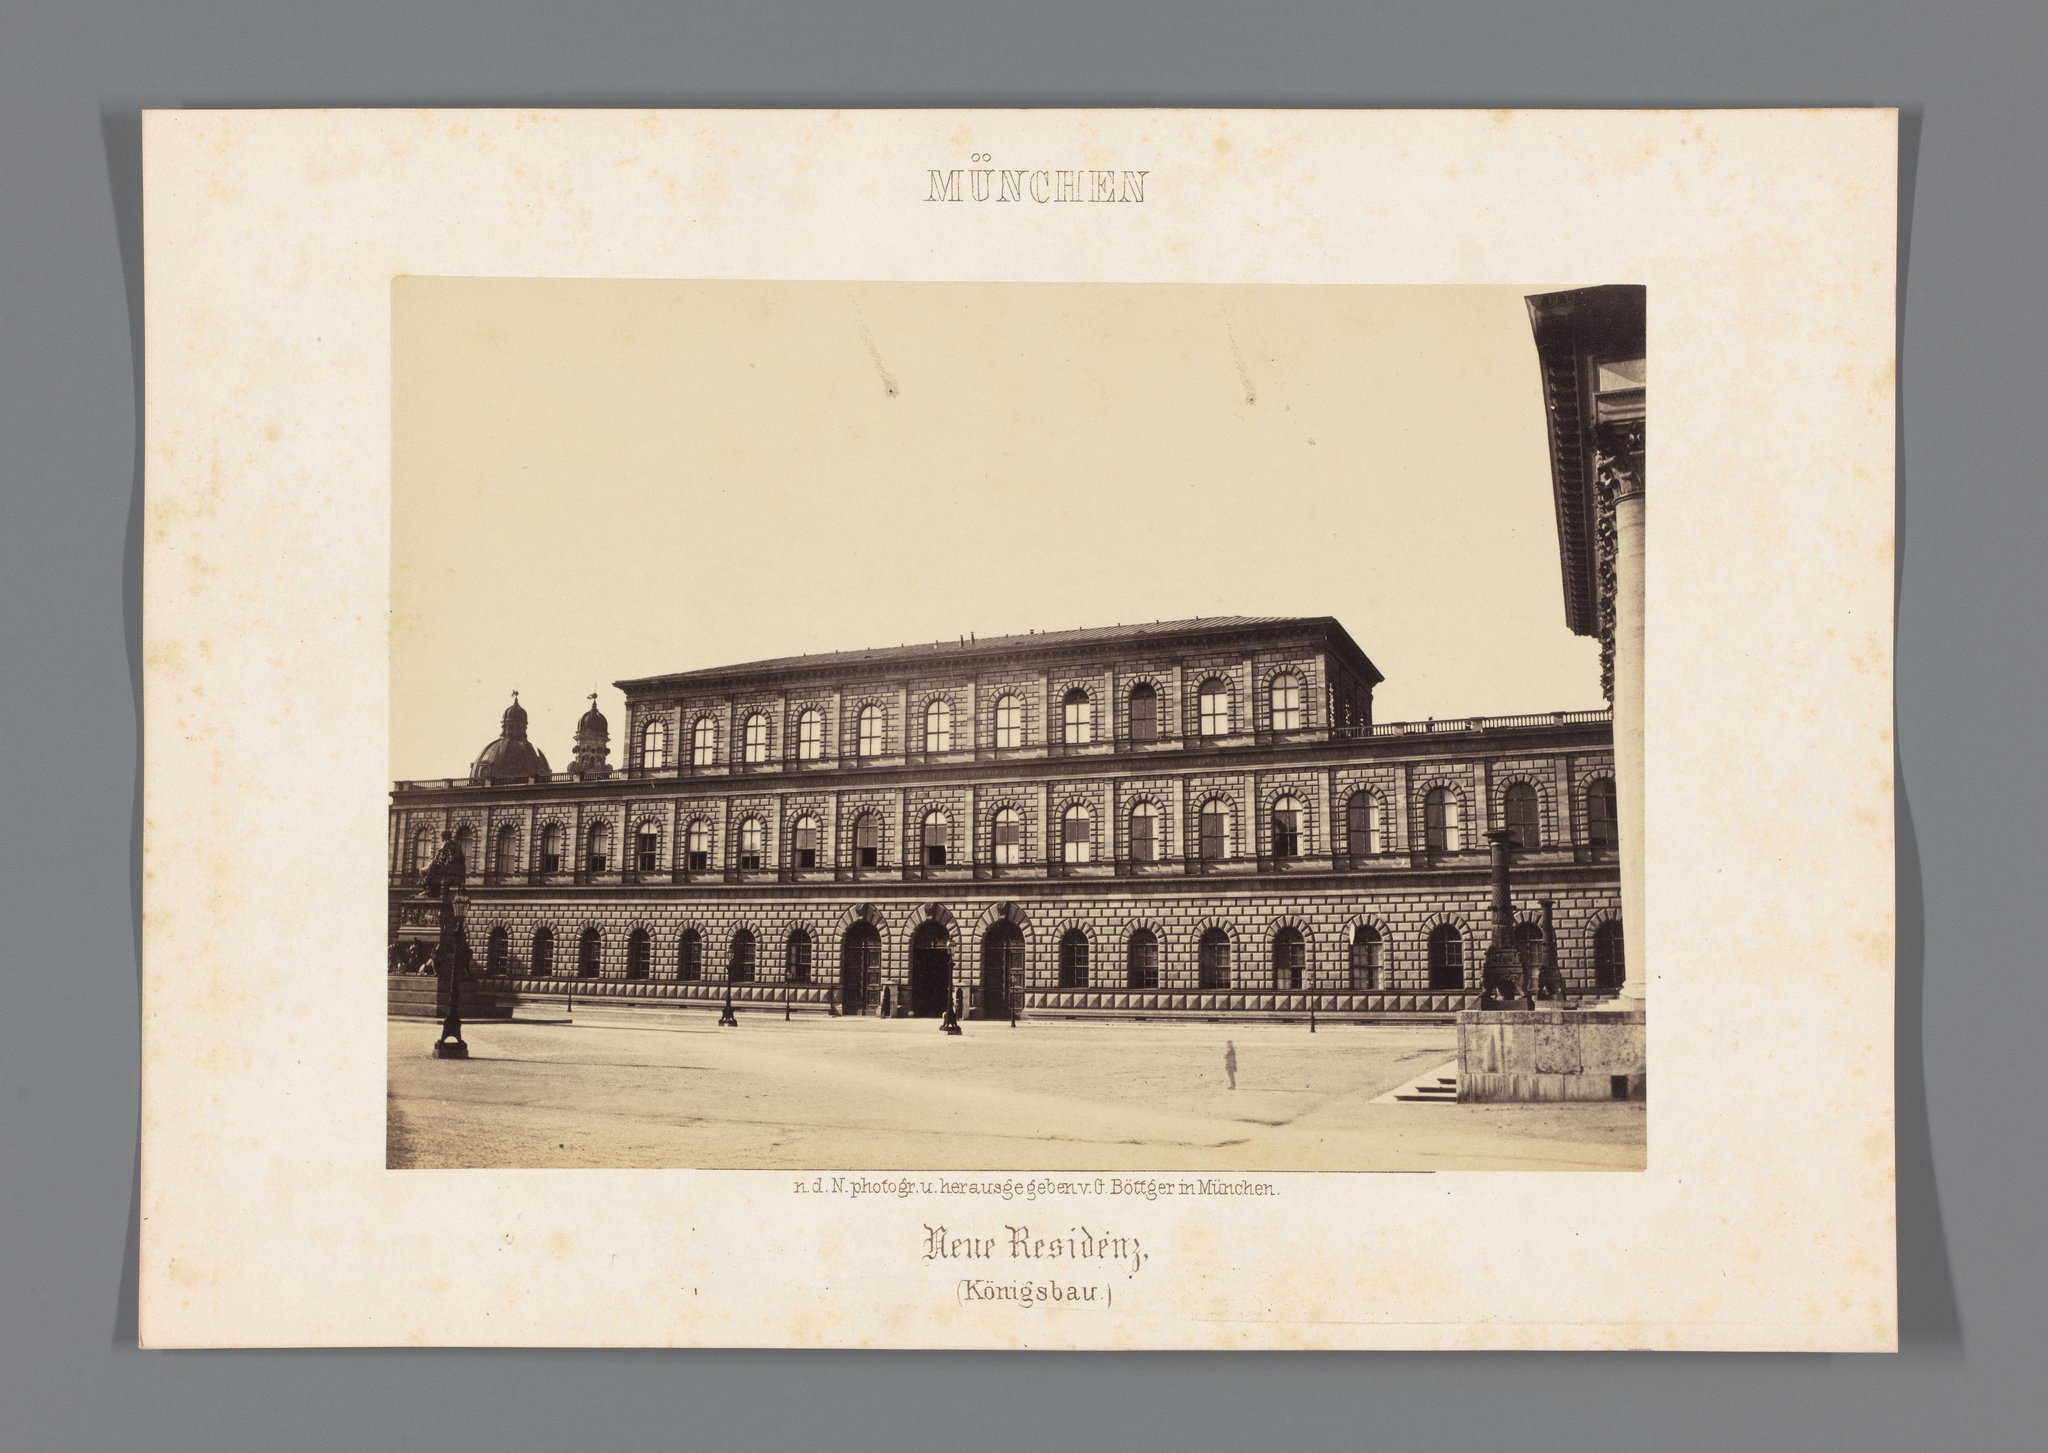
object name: photograph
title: München, Theatinerkirche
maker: Anonymous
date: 1850-1900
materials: paper, photographic support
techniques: albumen print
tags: theatinerkerk